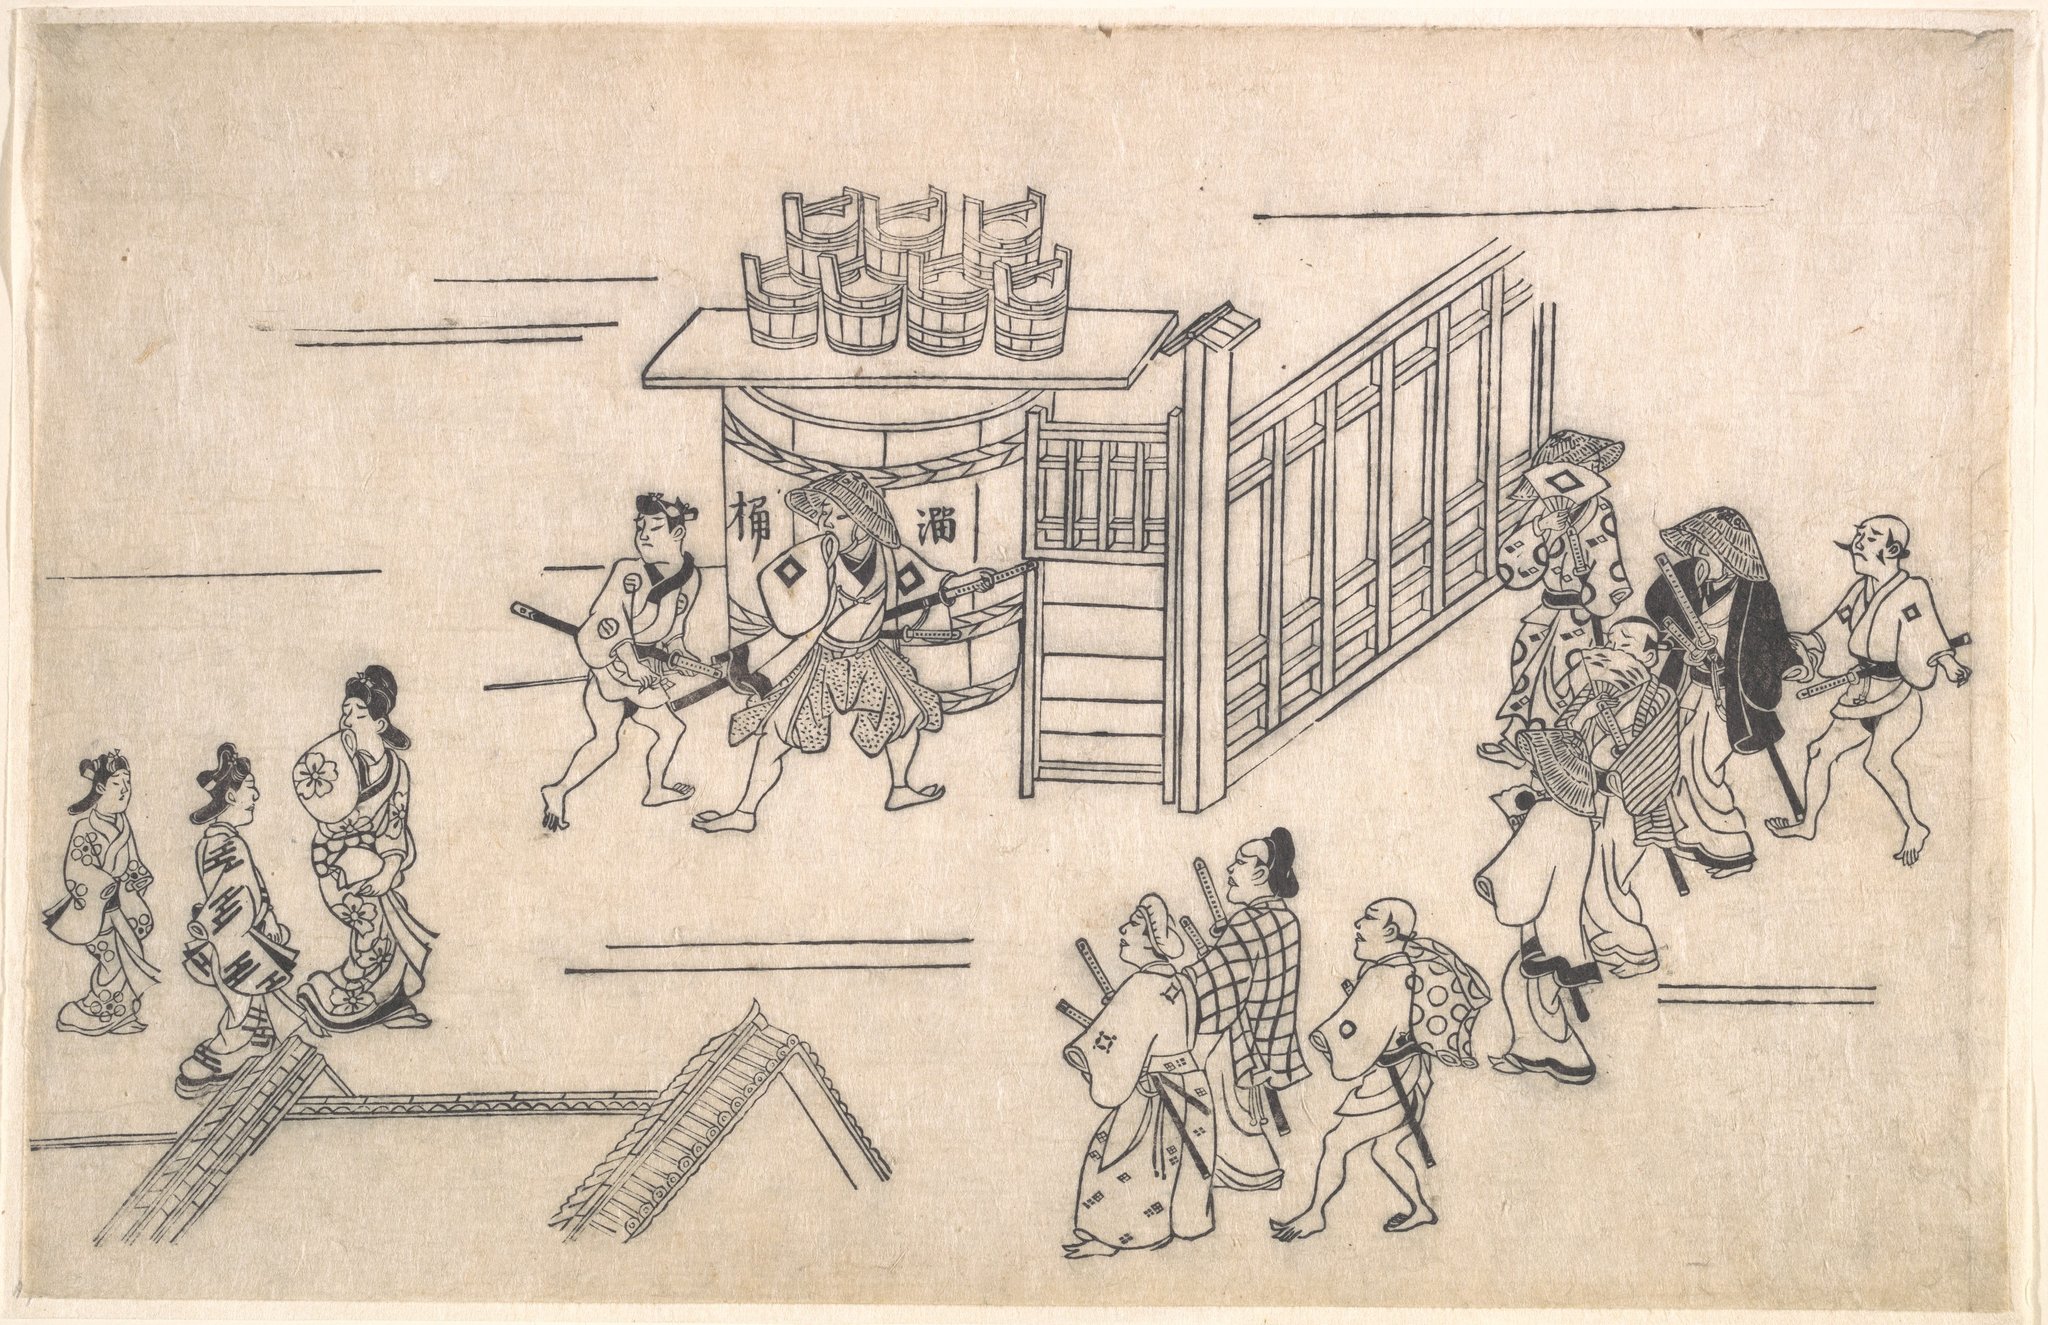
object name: print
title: The Fourth Scene, from the series Scenes of the Pleasure Quarter at Yoshiwara in Edo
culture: japanese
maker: hishikawa moronobu 菱川師宣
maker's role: artist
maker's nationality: japanese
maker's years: 1618-1694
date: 1615-1868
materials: ink, paper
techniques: woodblock print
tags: weapons,men,women